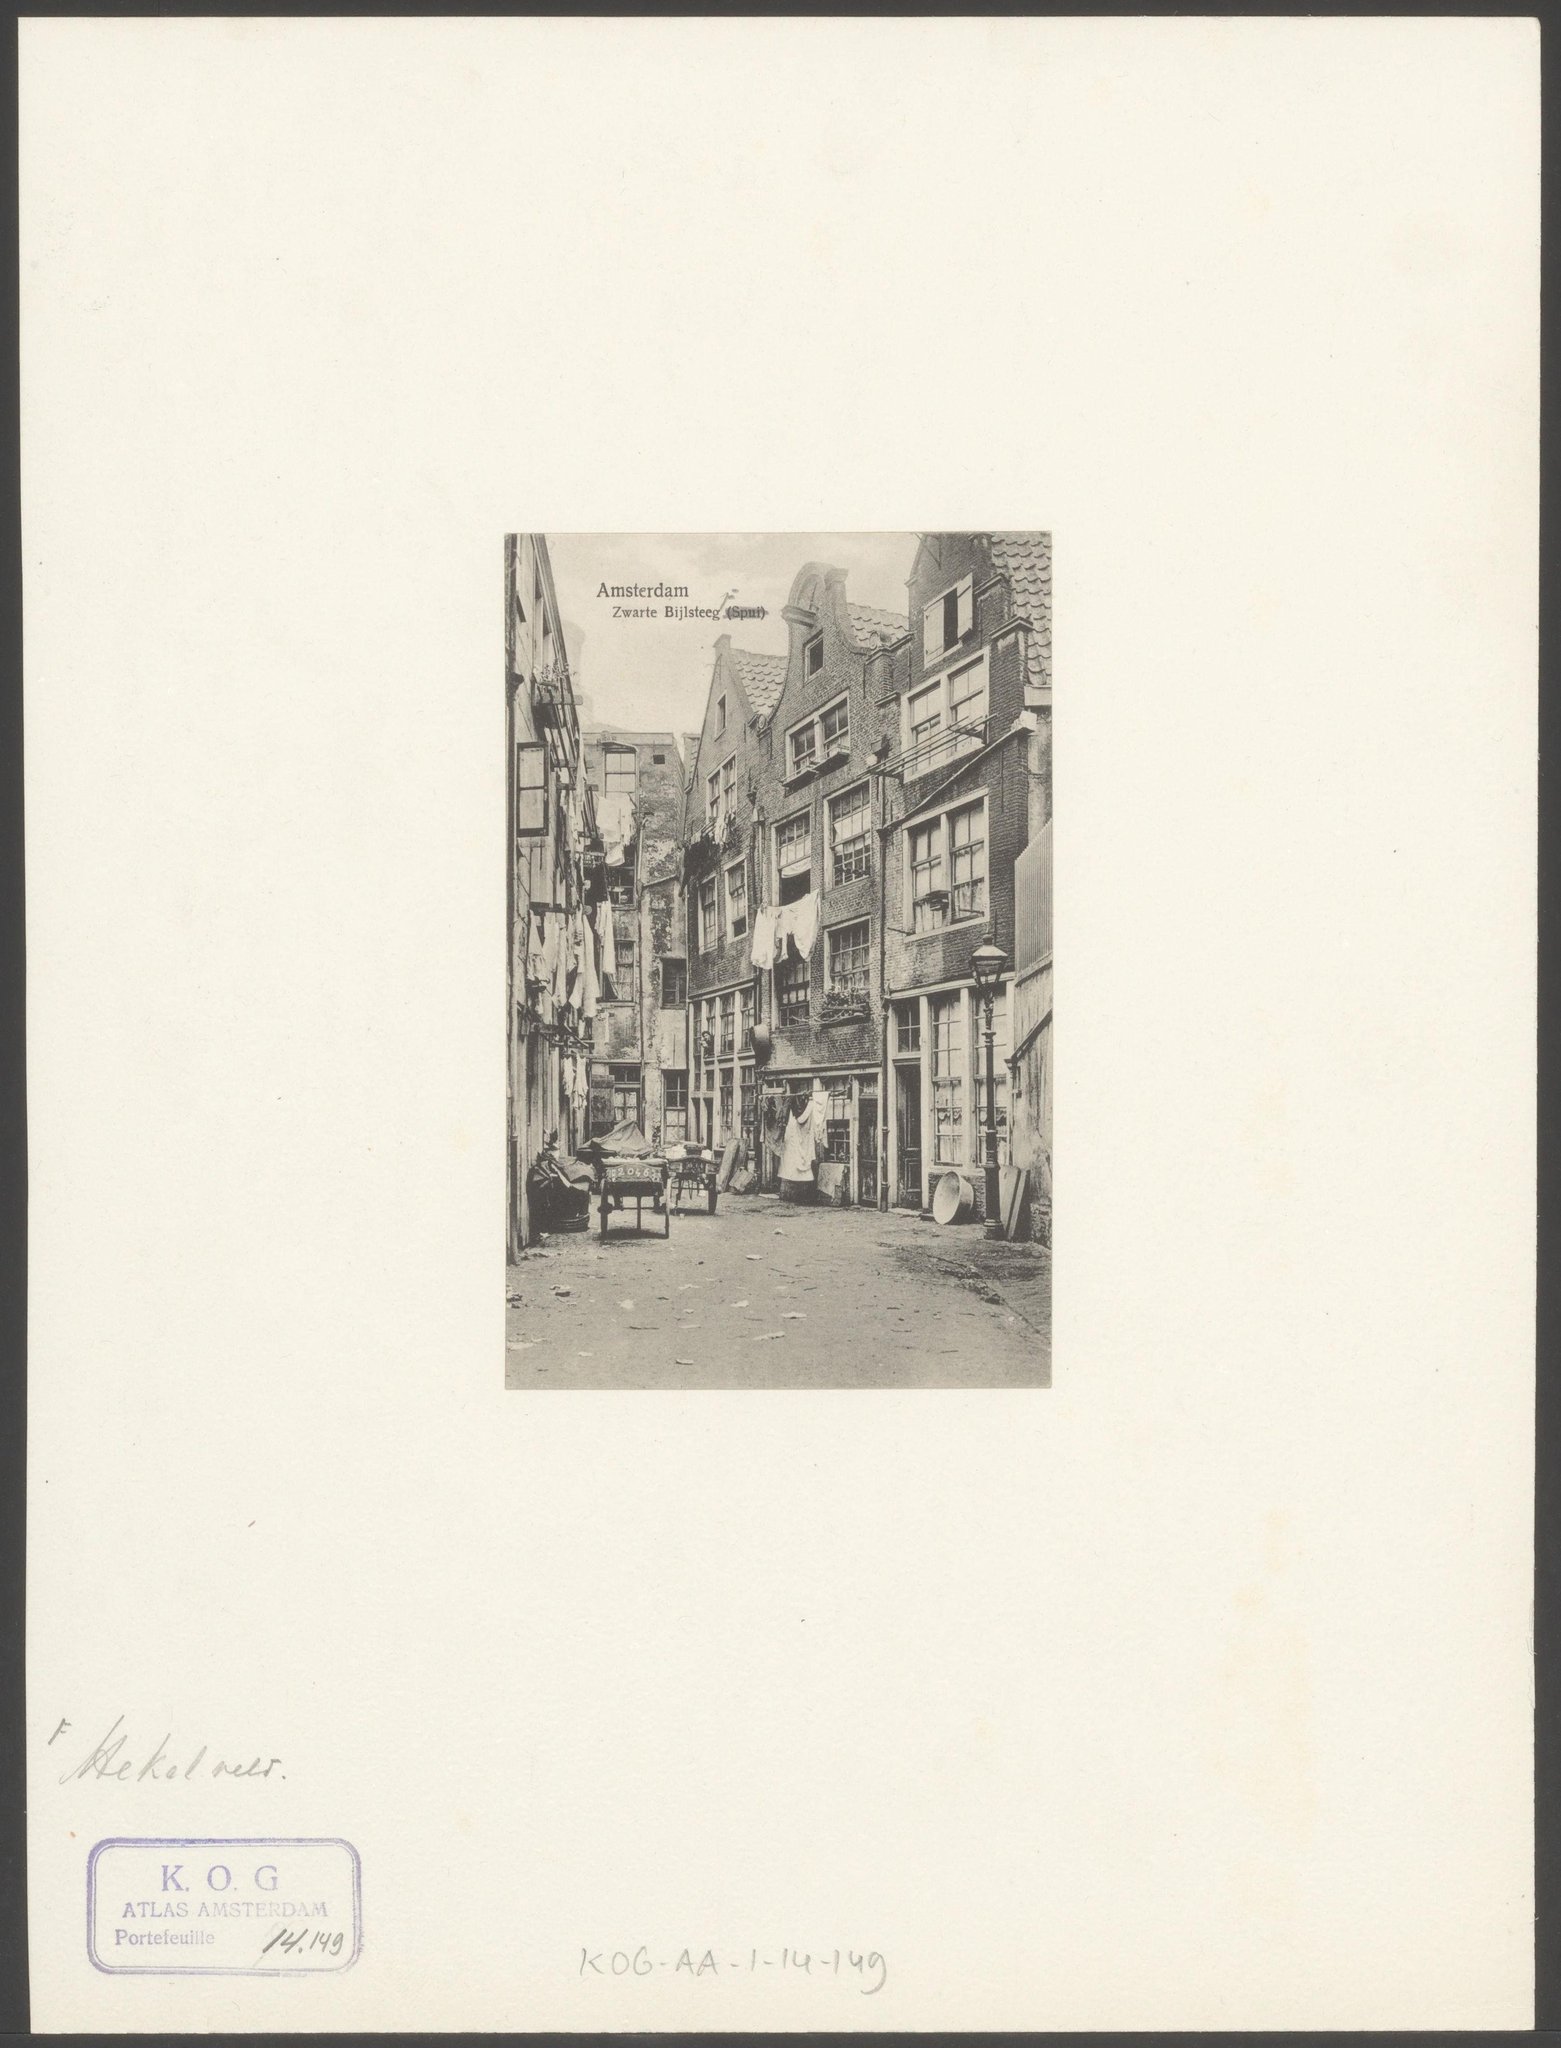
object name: ansichtkaart, prentbriefkaart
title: Gezicht op de Zwarte Bijlsteeg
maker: Anonymous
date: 1905-1930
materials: paper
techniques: photograph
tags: city-view in general; 'veduta', the usual house or row of houses, lane, alley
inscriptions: collector's mark: ‘14 149’ Lugt 1641b, inscription: ‘Hekelveld’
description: Onderwerpsrubriek binnen de Atlas Amsterdam: Zaagmolensloot, Zandpad, Zeeburg, Zeeburgerdijk, Zeeburgerpad, Zeeburgerstraat, Zwanenburgwal, Zwartebijlsteeg.